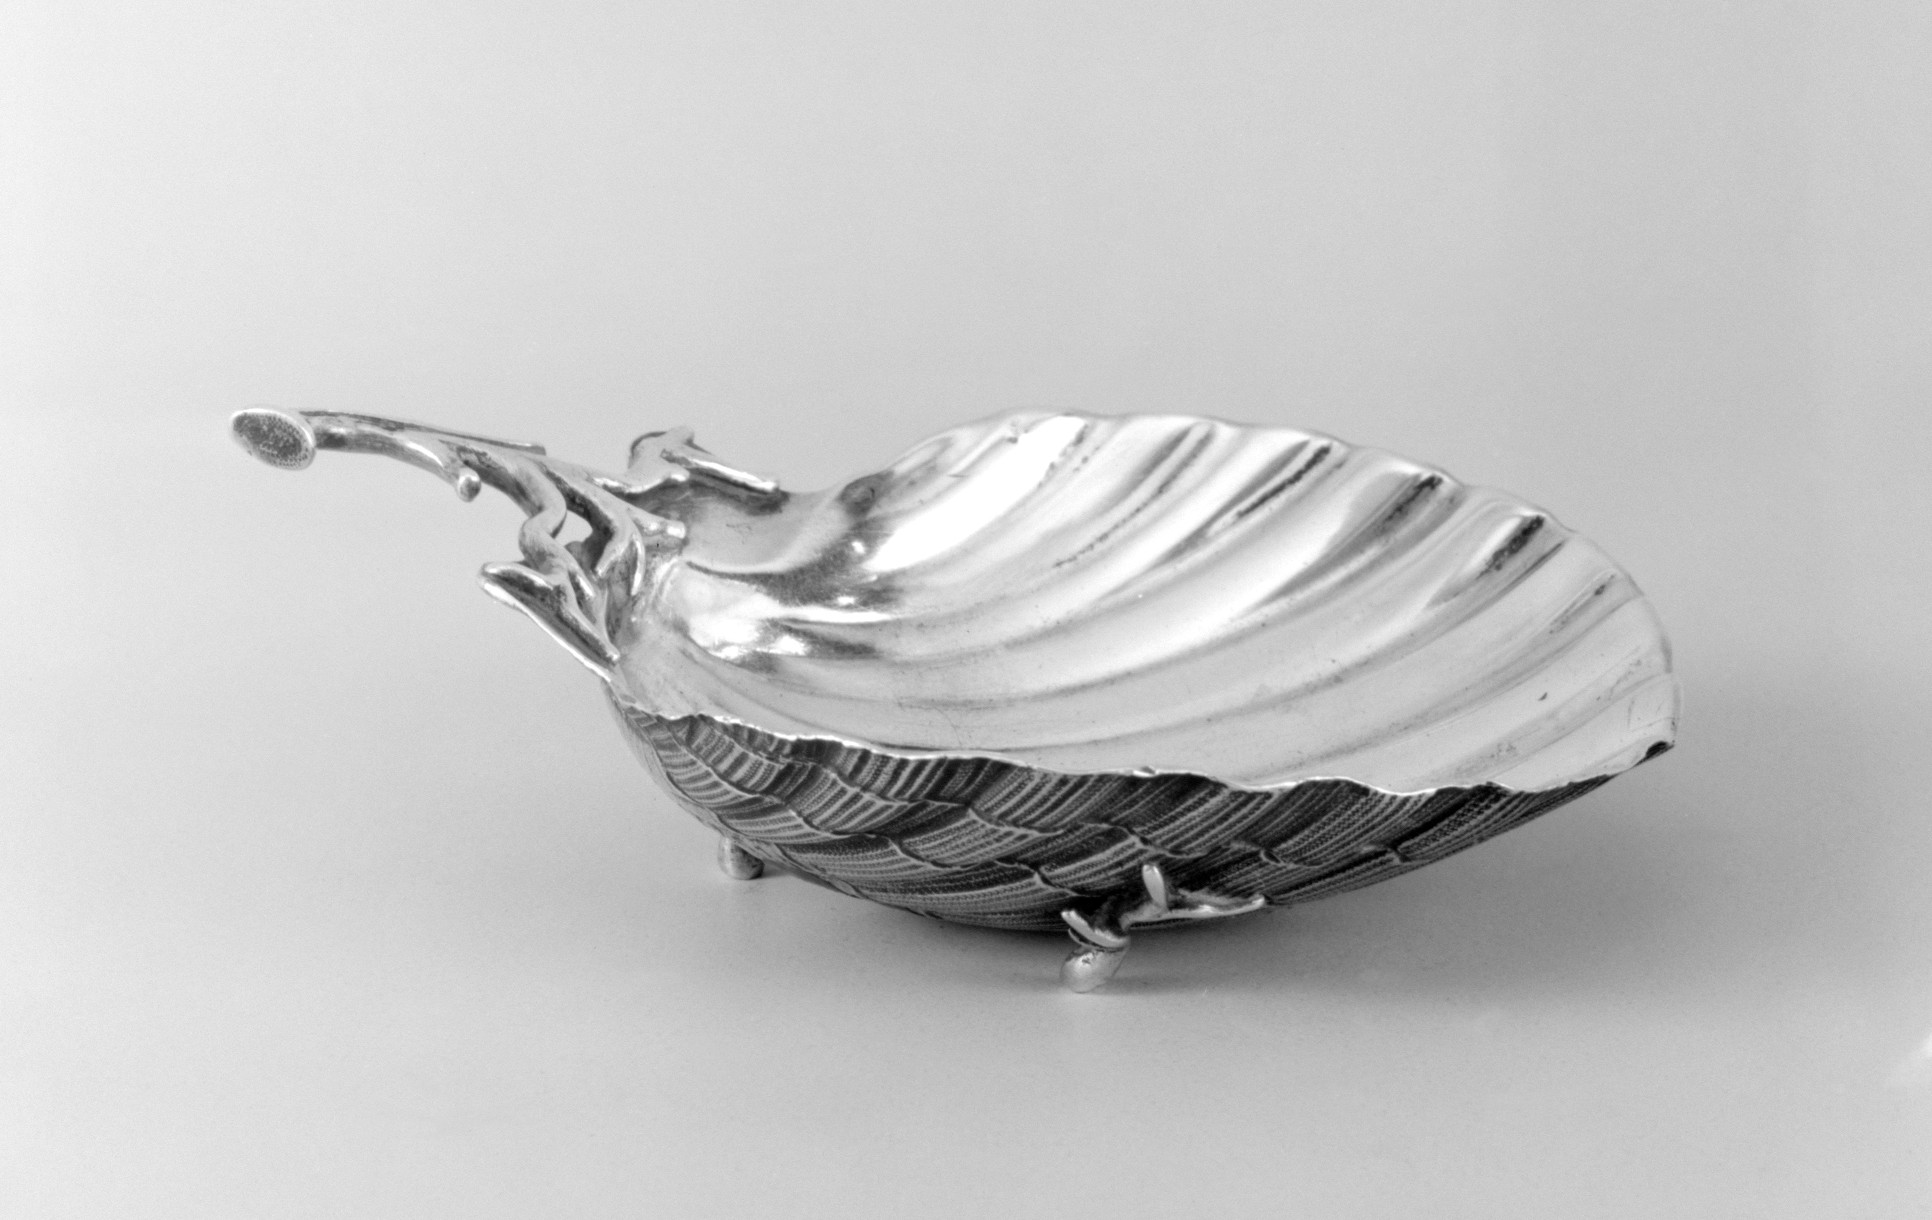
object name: dish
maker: louis regnard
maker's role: maker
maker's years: 1679-1779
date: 1753-1754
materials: silver